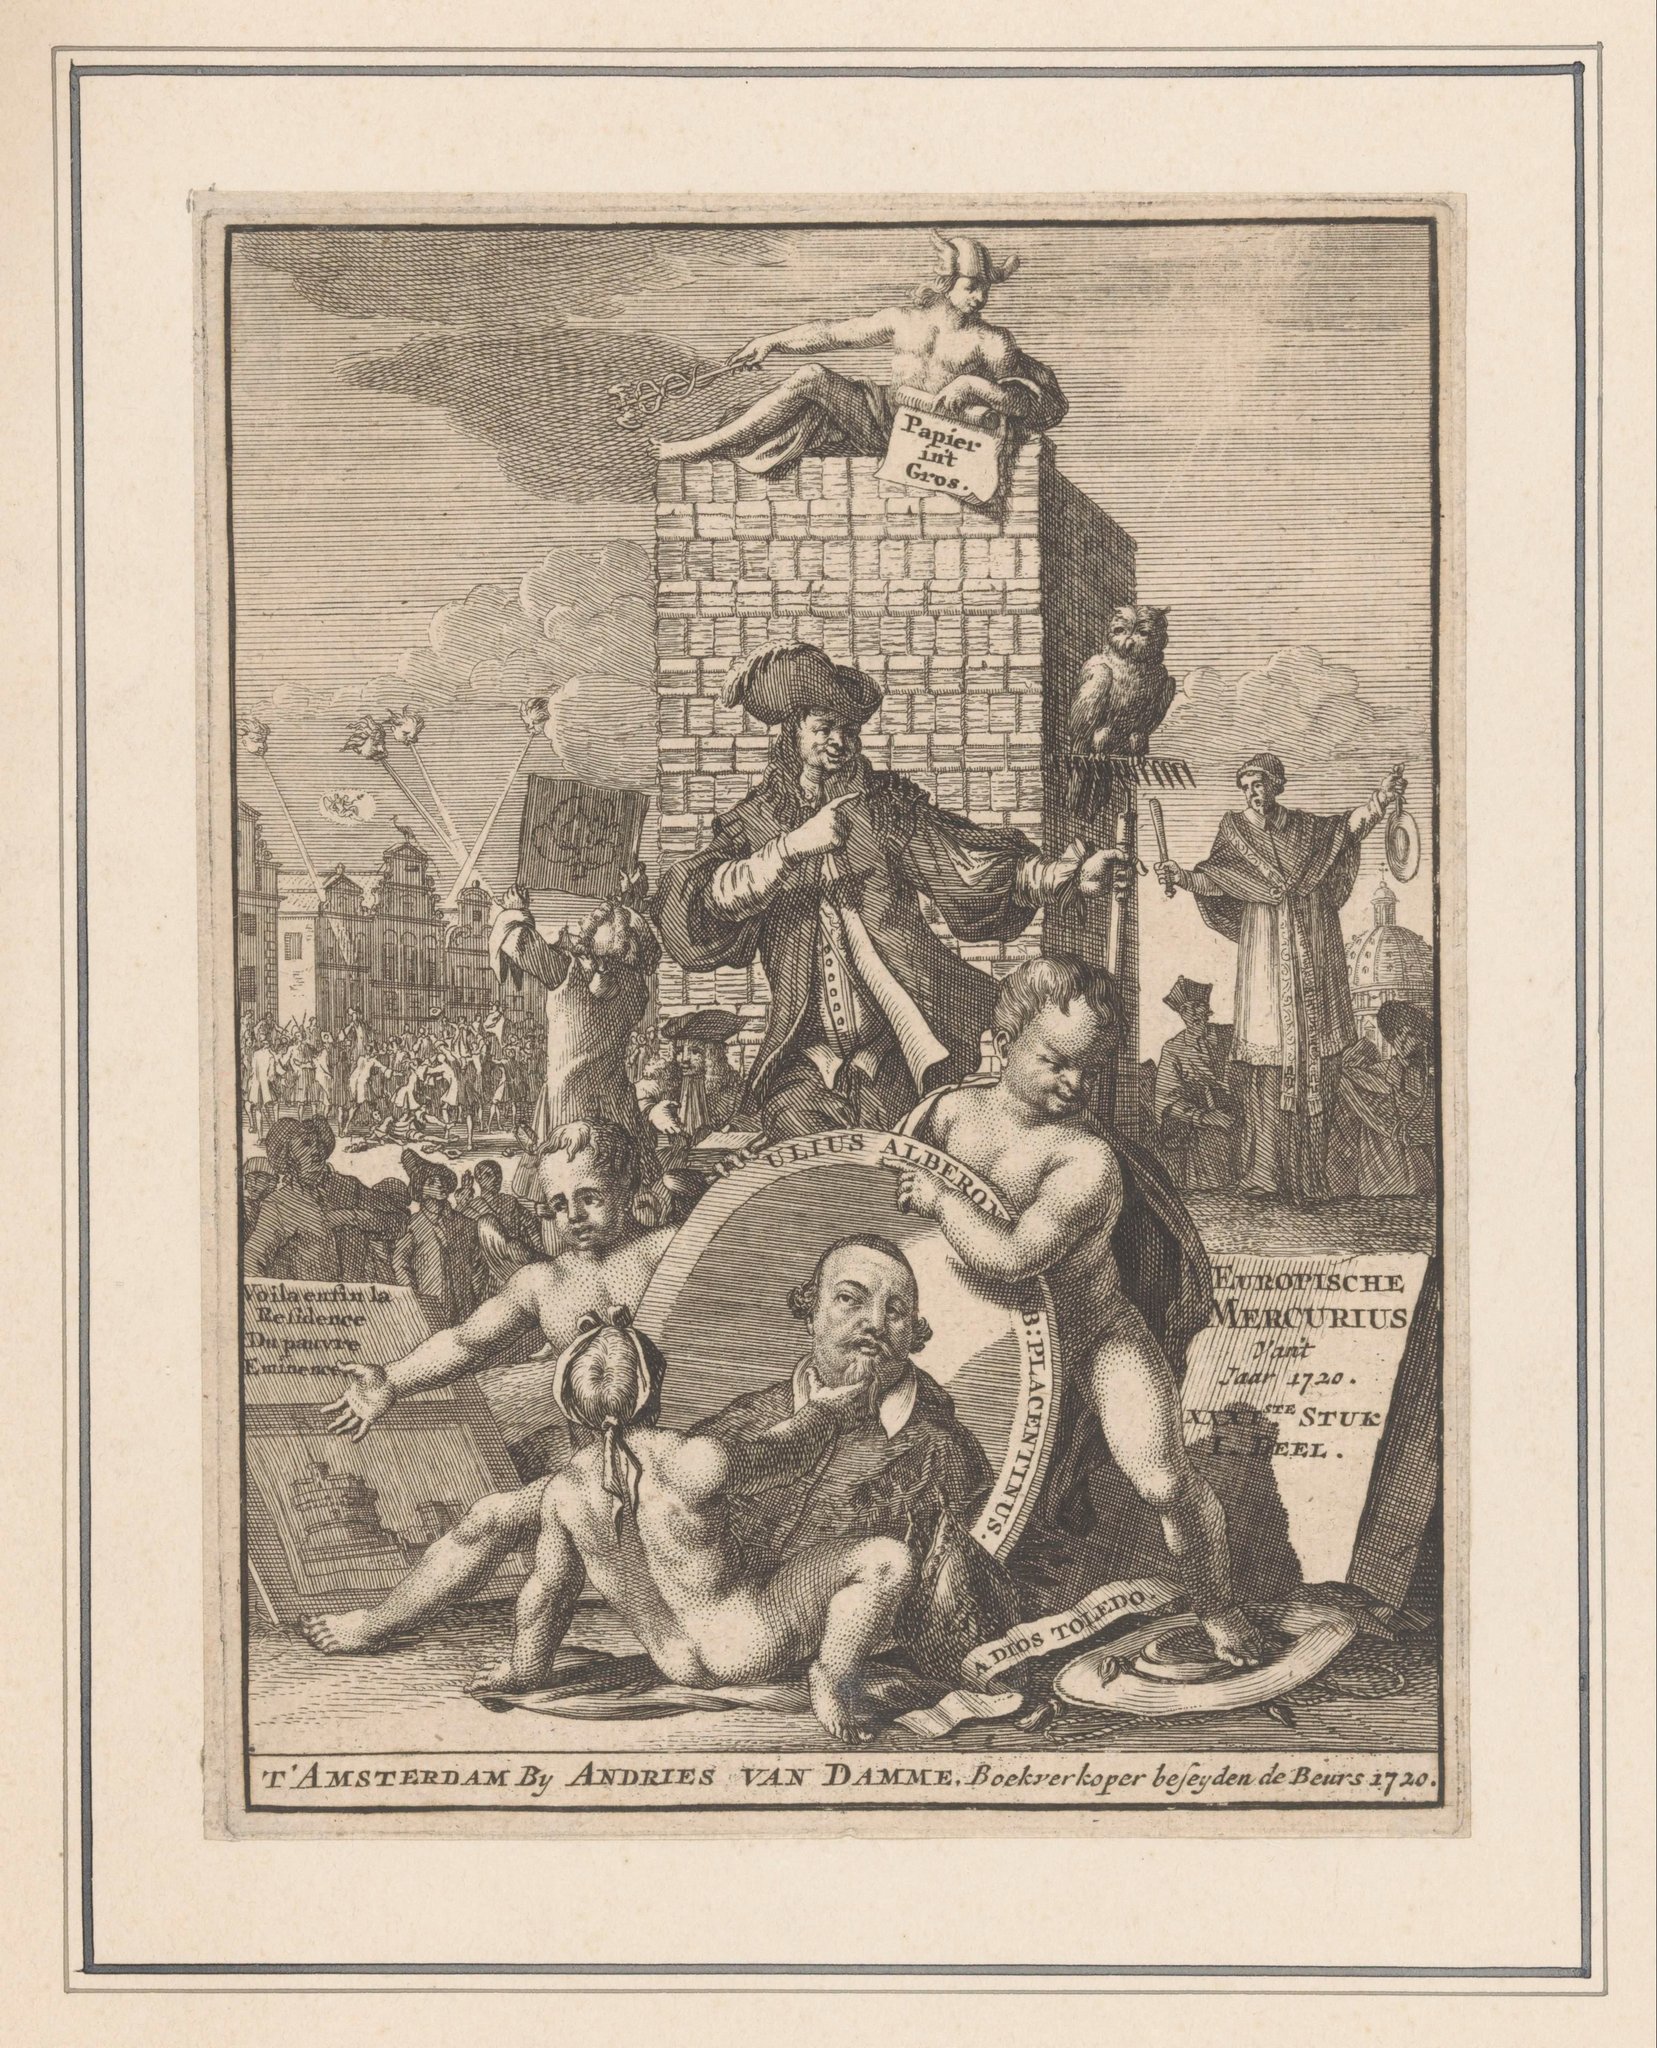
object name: print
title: Portret van kardinaal Giulio Alberoni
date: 1720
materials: paper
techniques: engraving, etching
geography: amsterdam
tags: piacenza, kardinaal, giulio alberoni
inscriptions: collector's mark: Lugt 2228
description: Portret van kardinaal Giulio Alberoni in een ovale omlijsting met randschrift. Daar omheen een aantal allegorische objecten en figuren. De bespotting van dit portret verwijst naar de val en verbanning van de kardinaal uit Spanje in december 1719. Op de achtergrond Mercurius gezeten op een enorme stapel papier.